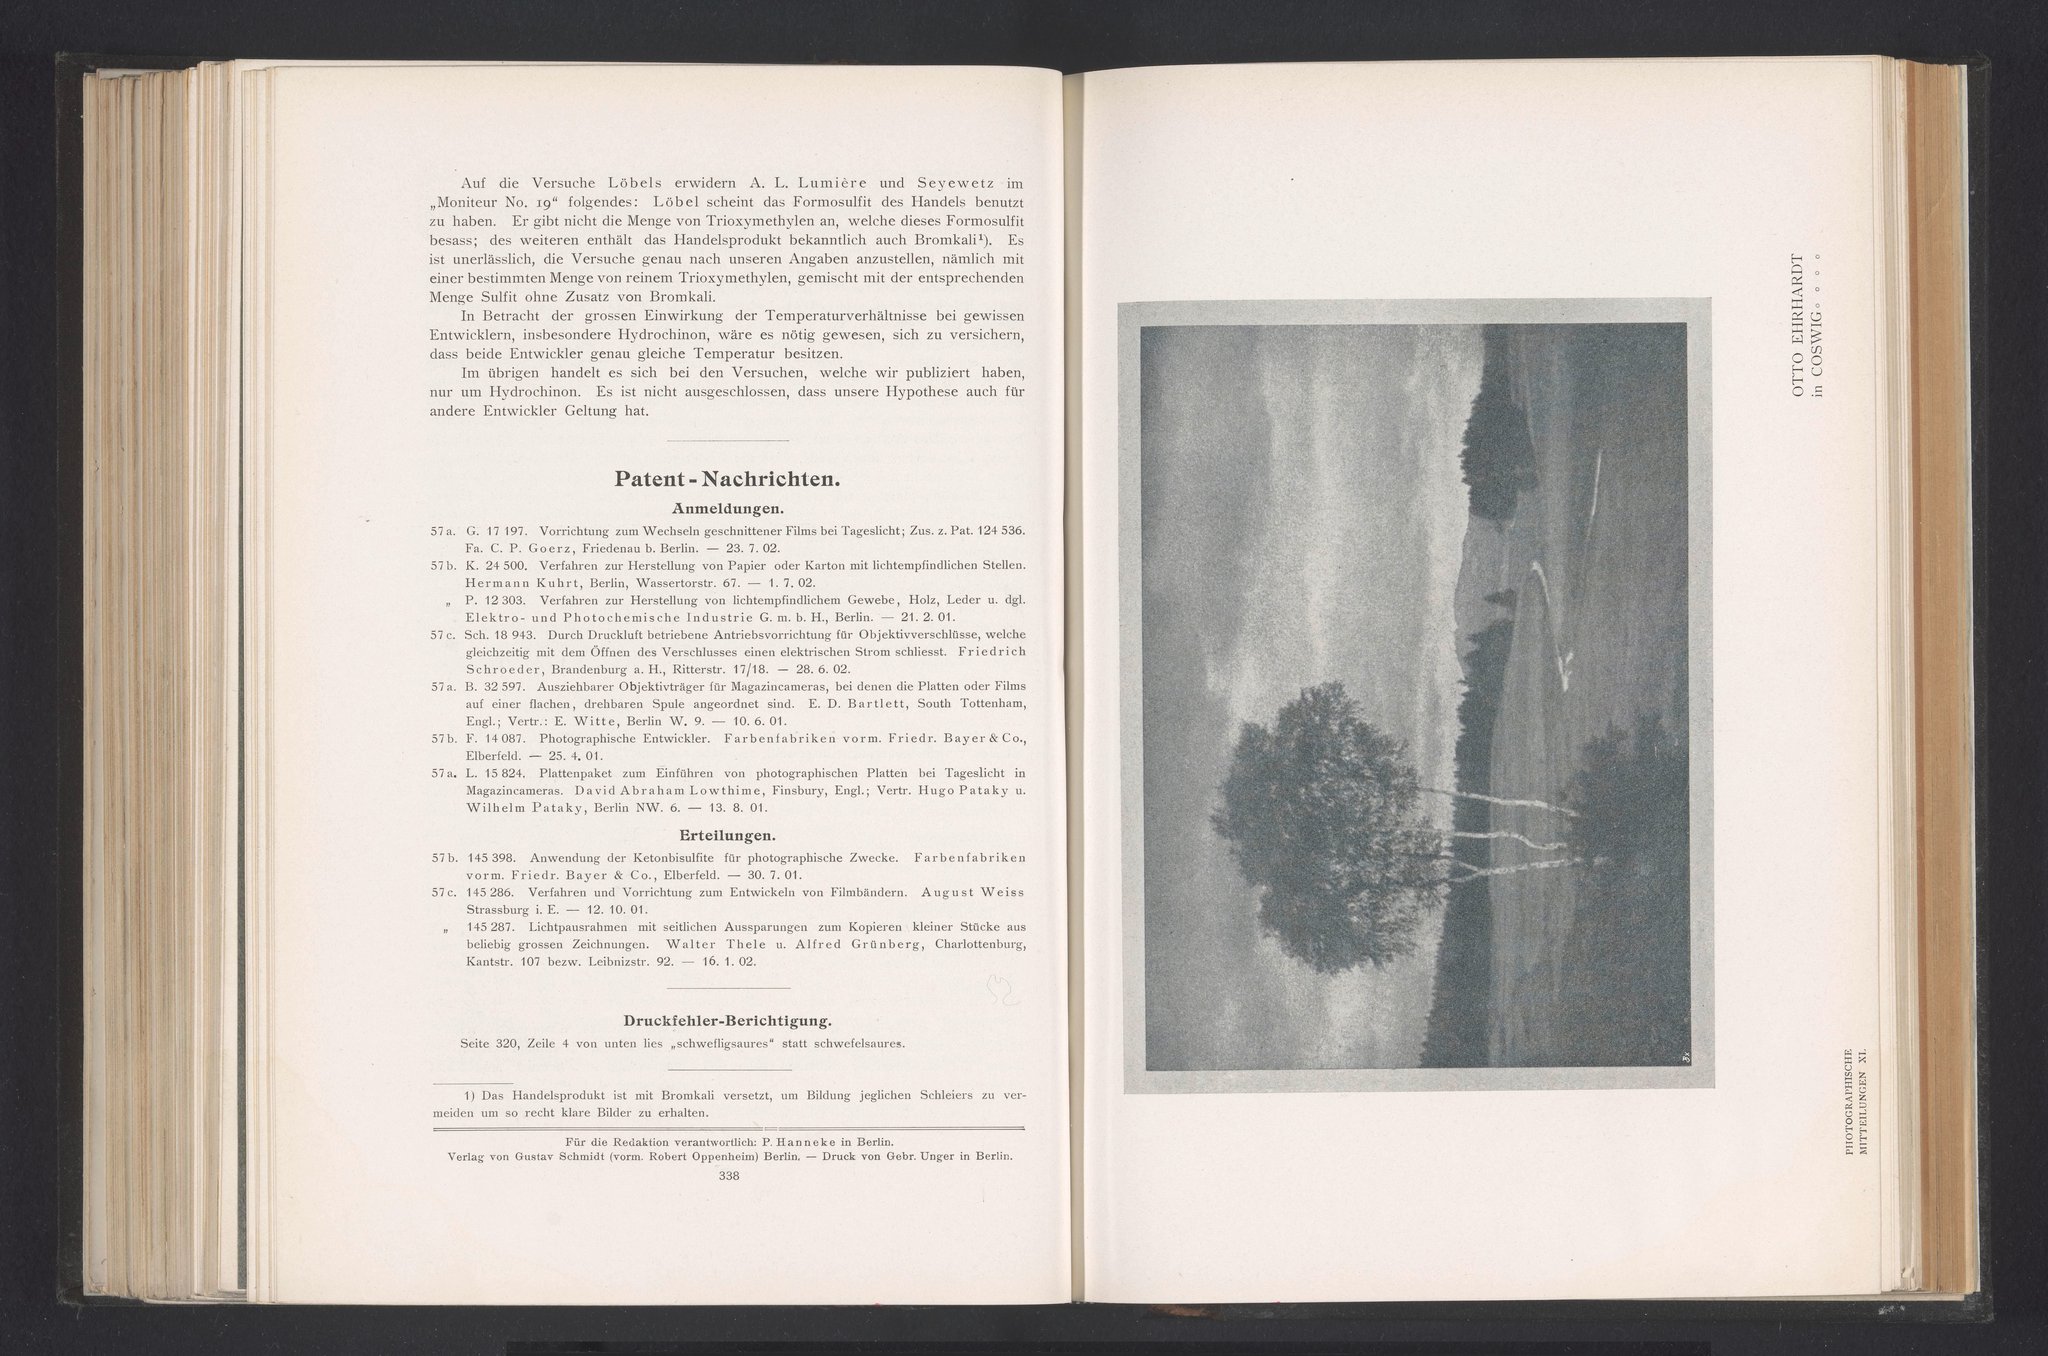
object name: page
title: Landschap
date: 1898-1903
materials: paper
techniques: autotype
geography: coswig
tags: landscapes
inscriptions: inscription: ‘Photographische Mitteilungen XL’, monogram: ‘BX’